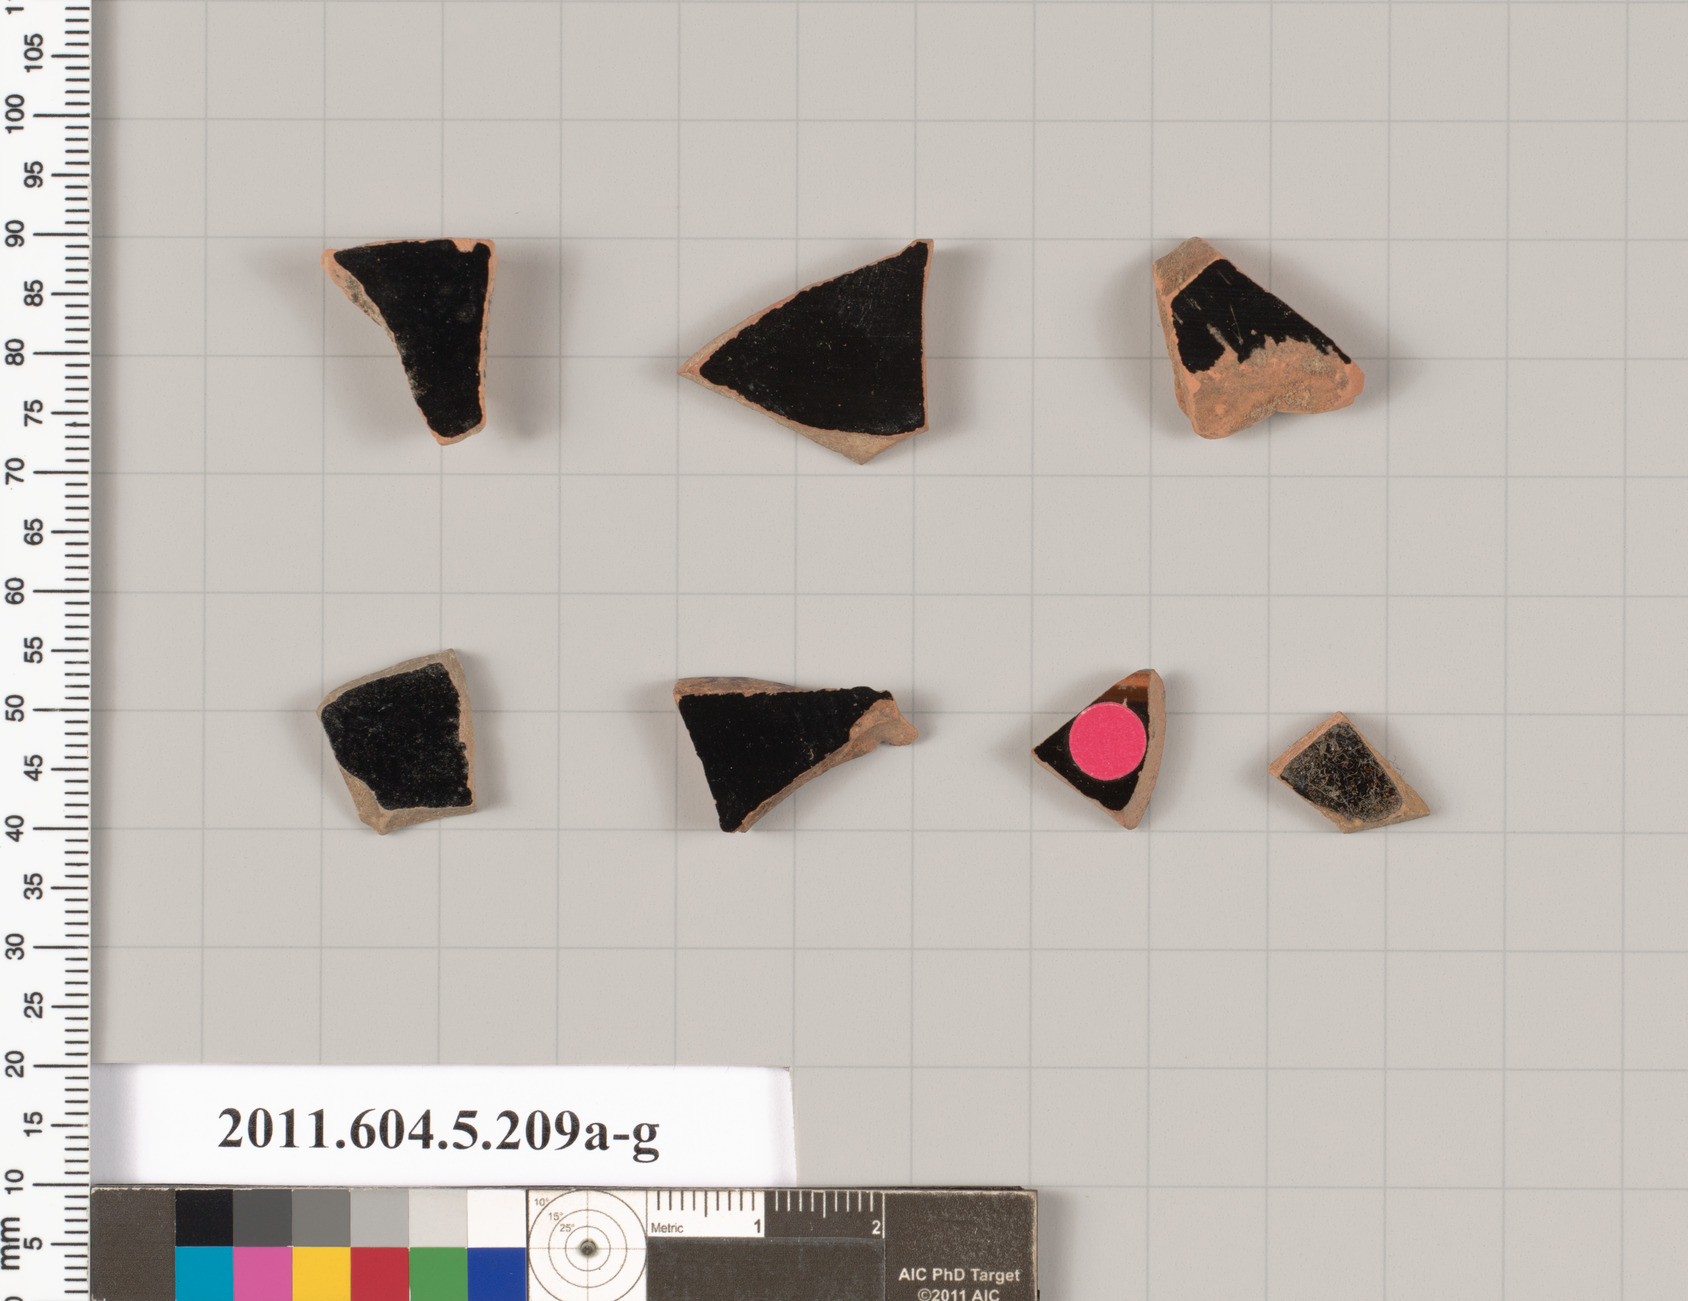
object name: kylix fragment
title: Terracotta fragments of kylikes (drinking cups)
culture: greek, attic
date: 600-401 BCE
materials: terracotta